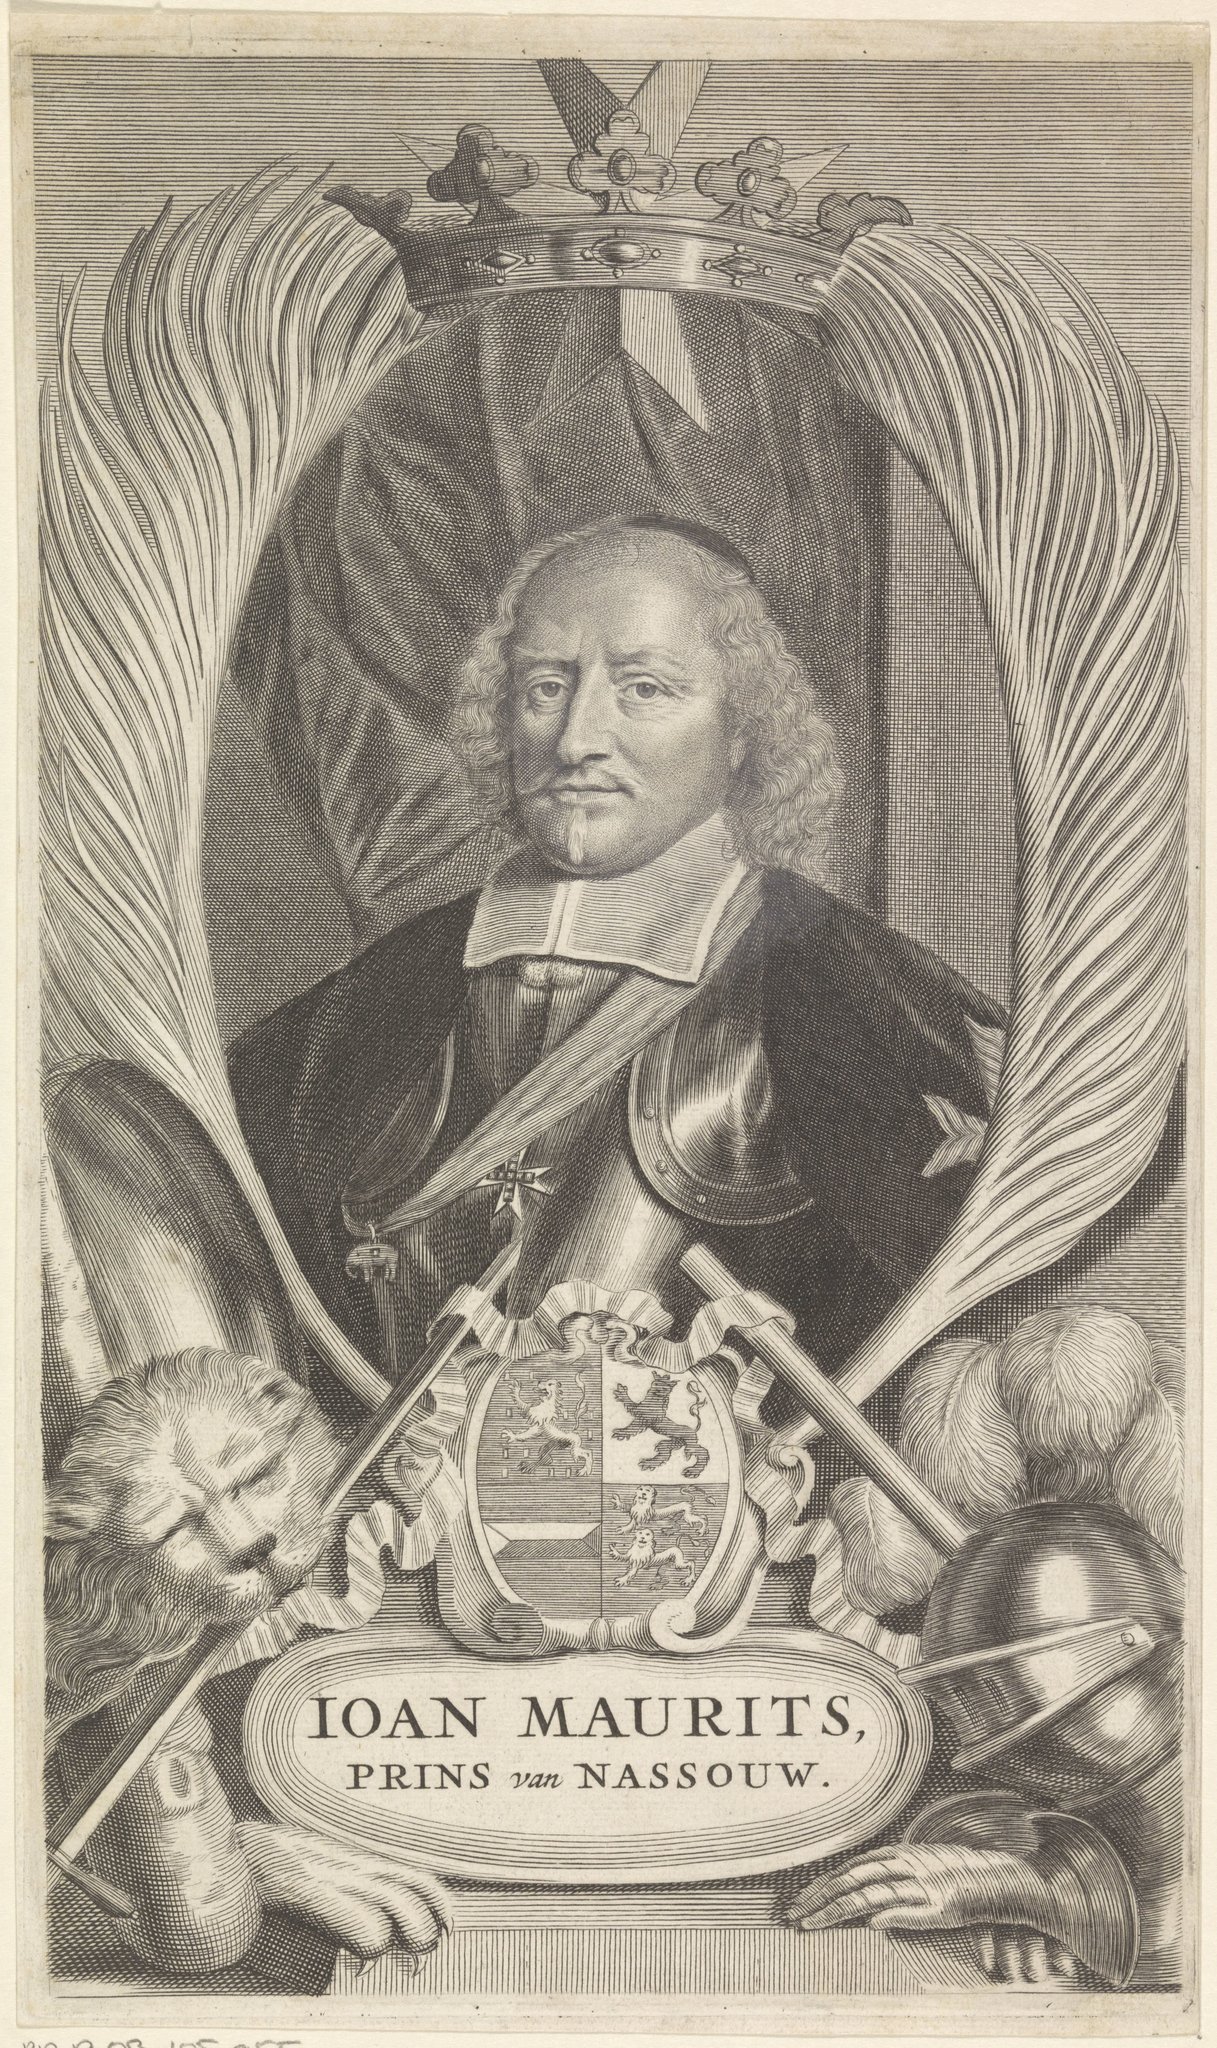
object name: print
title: Portret van Johan Maurits, graaf van Nassau-Siegen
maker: Anonymous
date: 1625-1699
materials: paper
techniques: engraving, etching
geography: low countries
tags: earl, johan maurits graaf van nassau-siegen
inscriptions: collector's mark: Lugt 963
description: Portret van Johan Maurits in een ovaal van palmtakken. Daar omheen een aantal allegorische objecten, waaronder een helm en een commandostaf. Midden boven een kroon. Midden onder zijn wapen. In een kader zijn naam en titel.